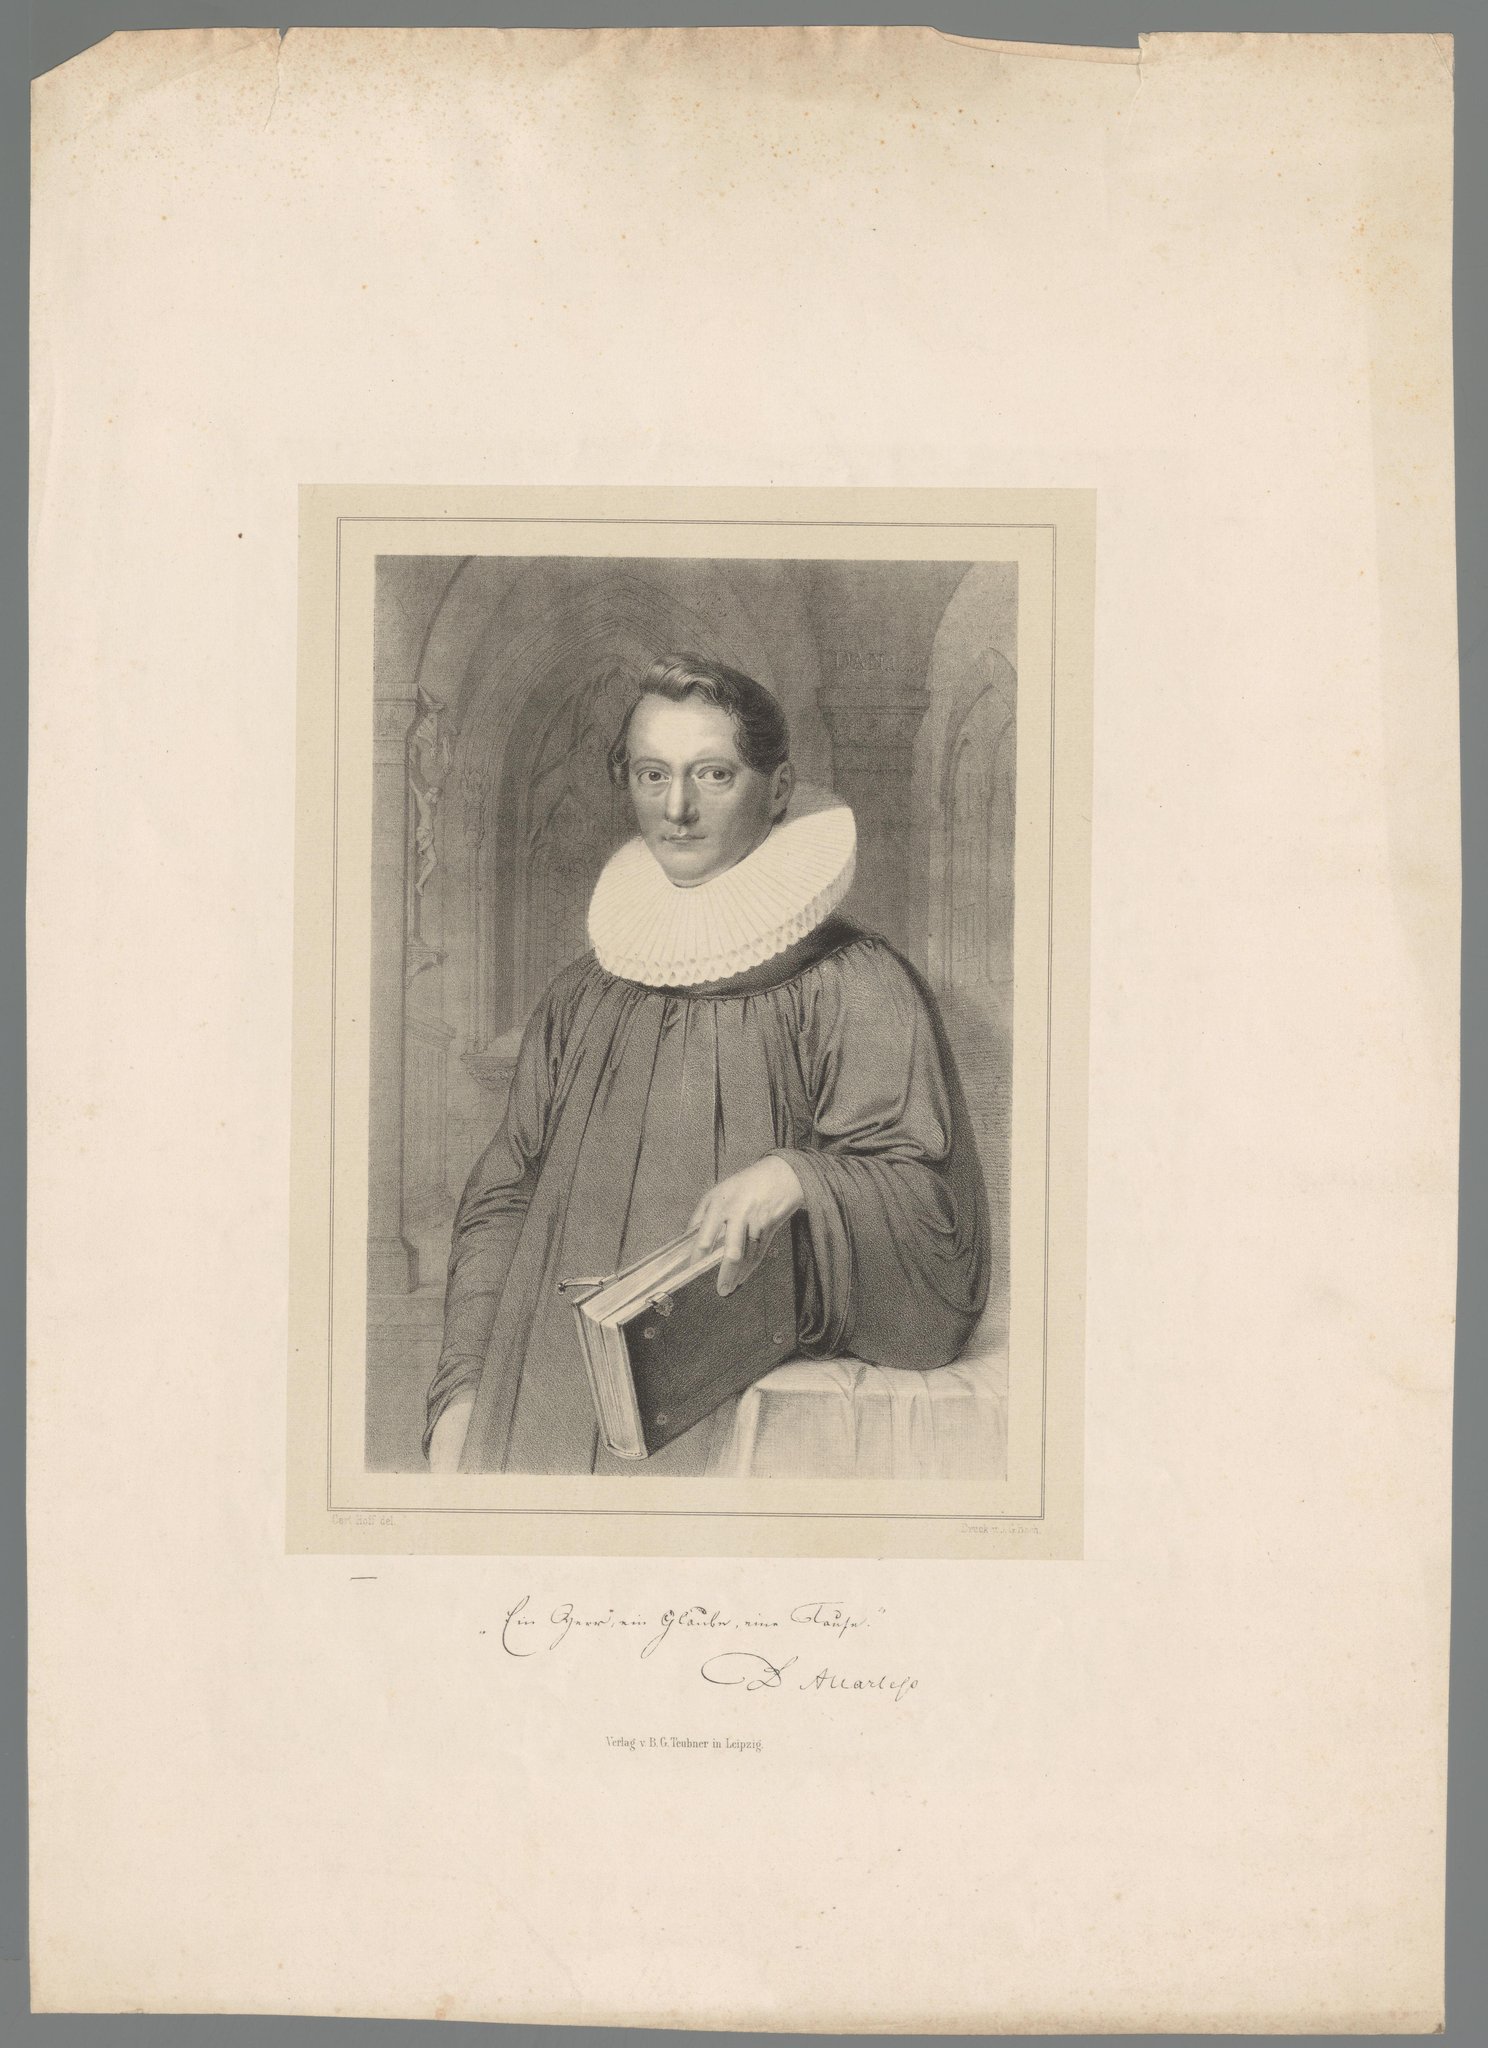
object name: print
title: Portret van een onbekende dominee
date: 1820-1875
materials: paper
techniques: lithograph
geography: leipzig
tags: historical persons, functionaries and dignitaries (with name) ~ protestant churches, neck-gear: collar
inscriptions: collector's mark: Lugt 2228